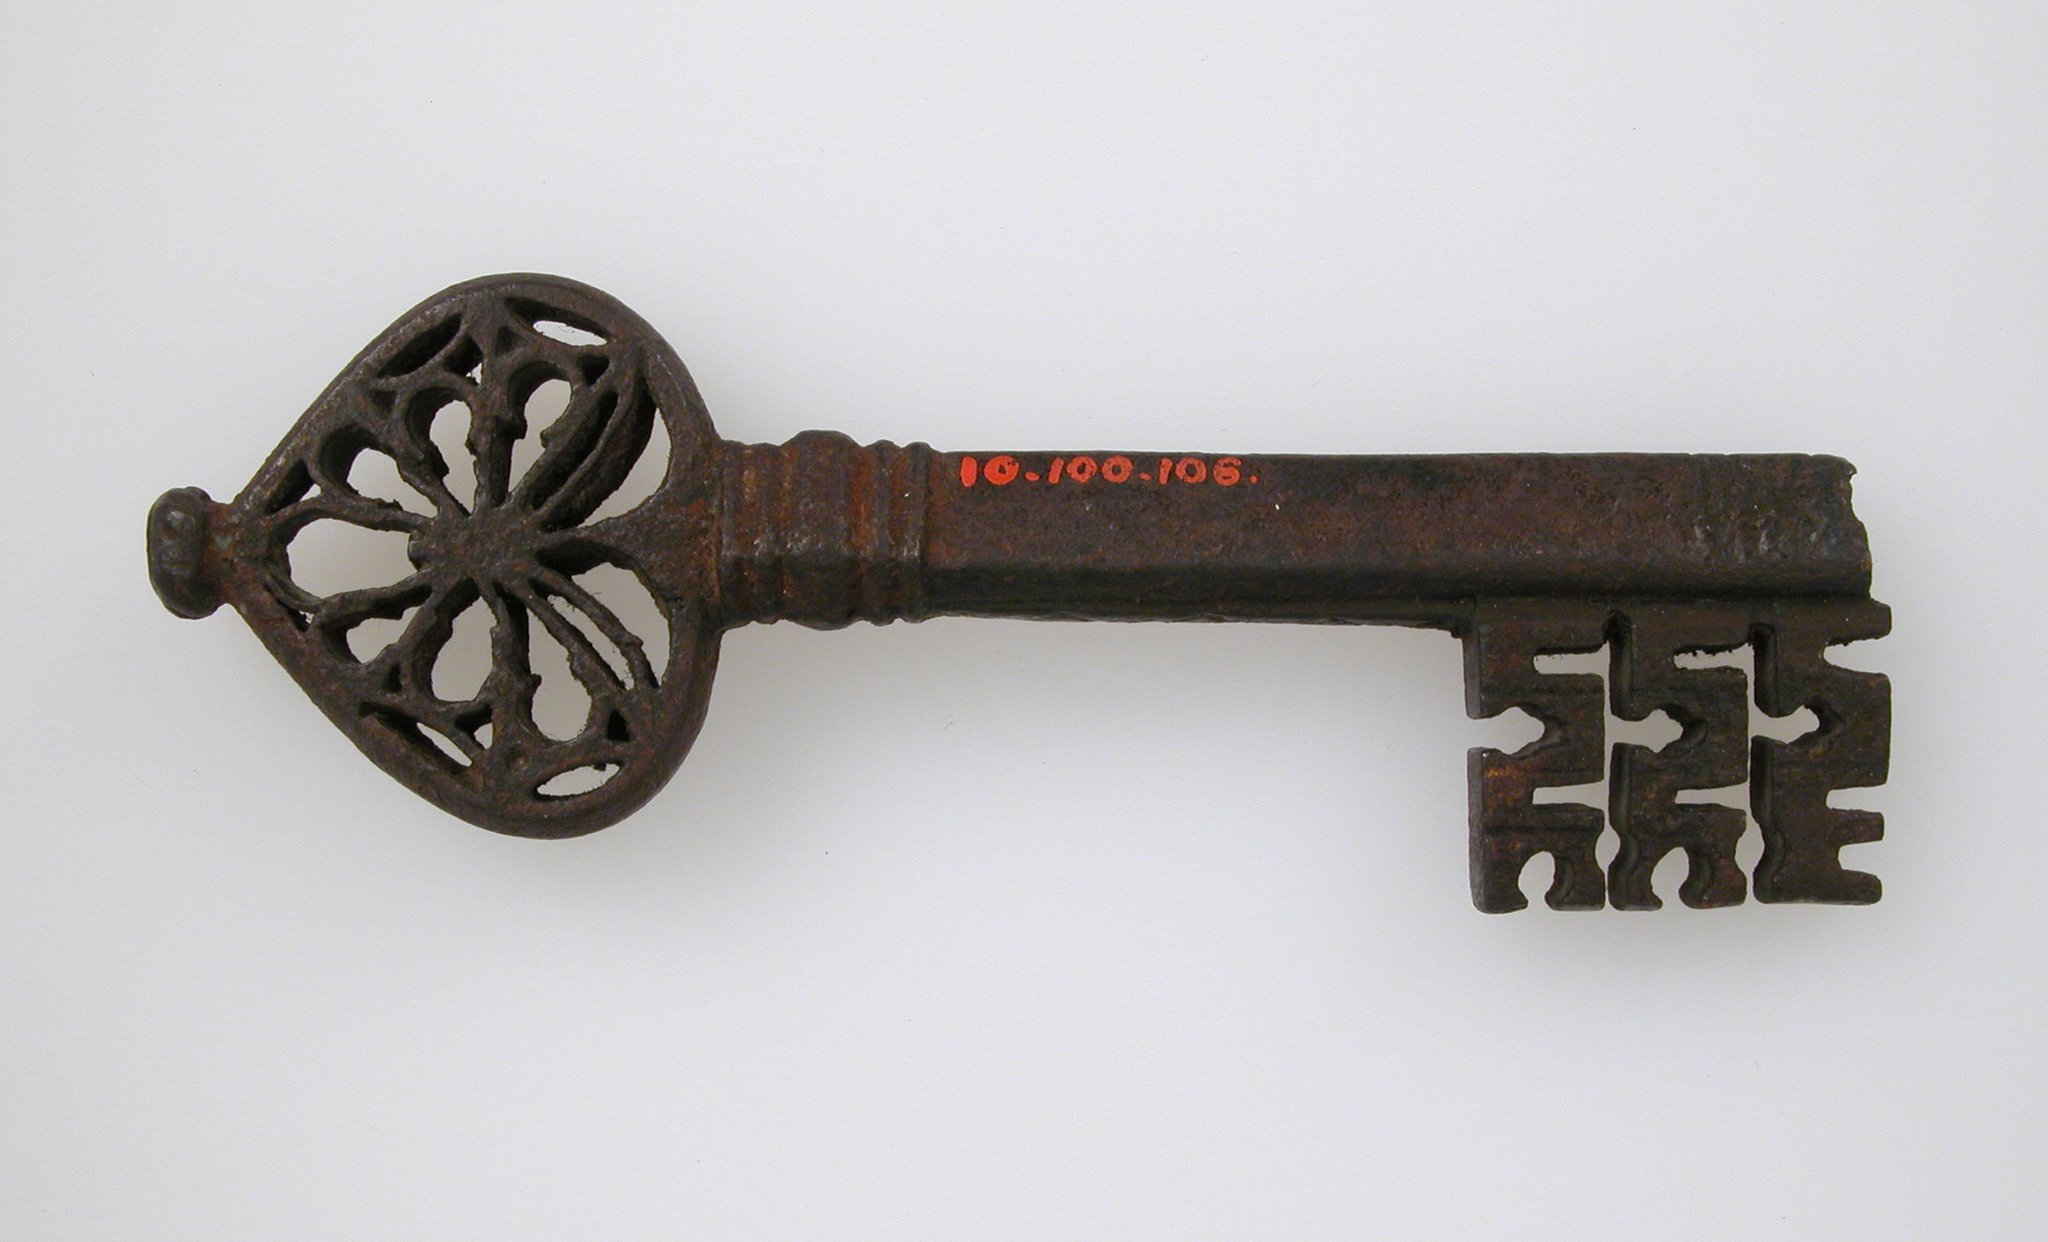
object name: key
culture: german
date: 1401-1500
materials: iron